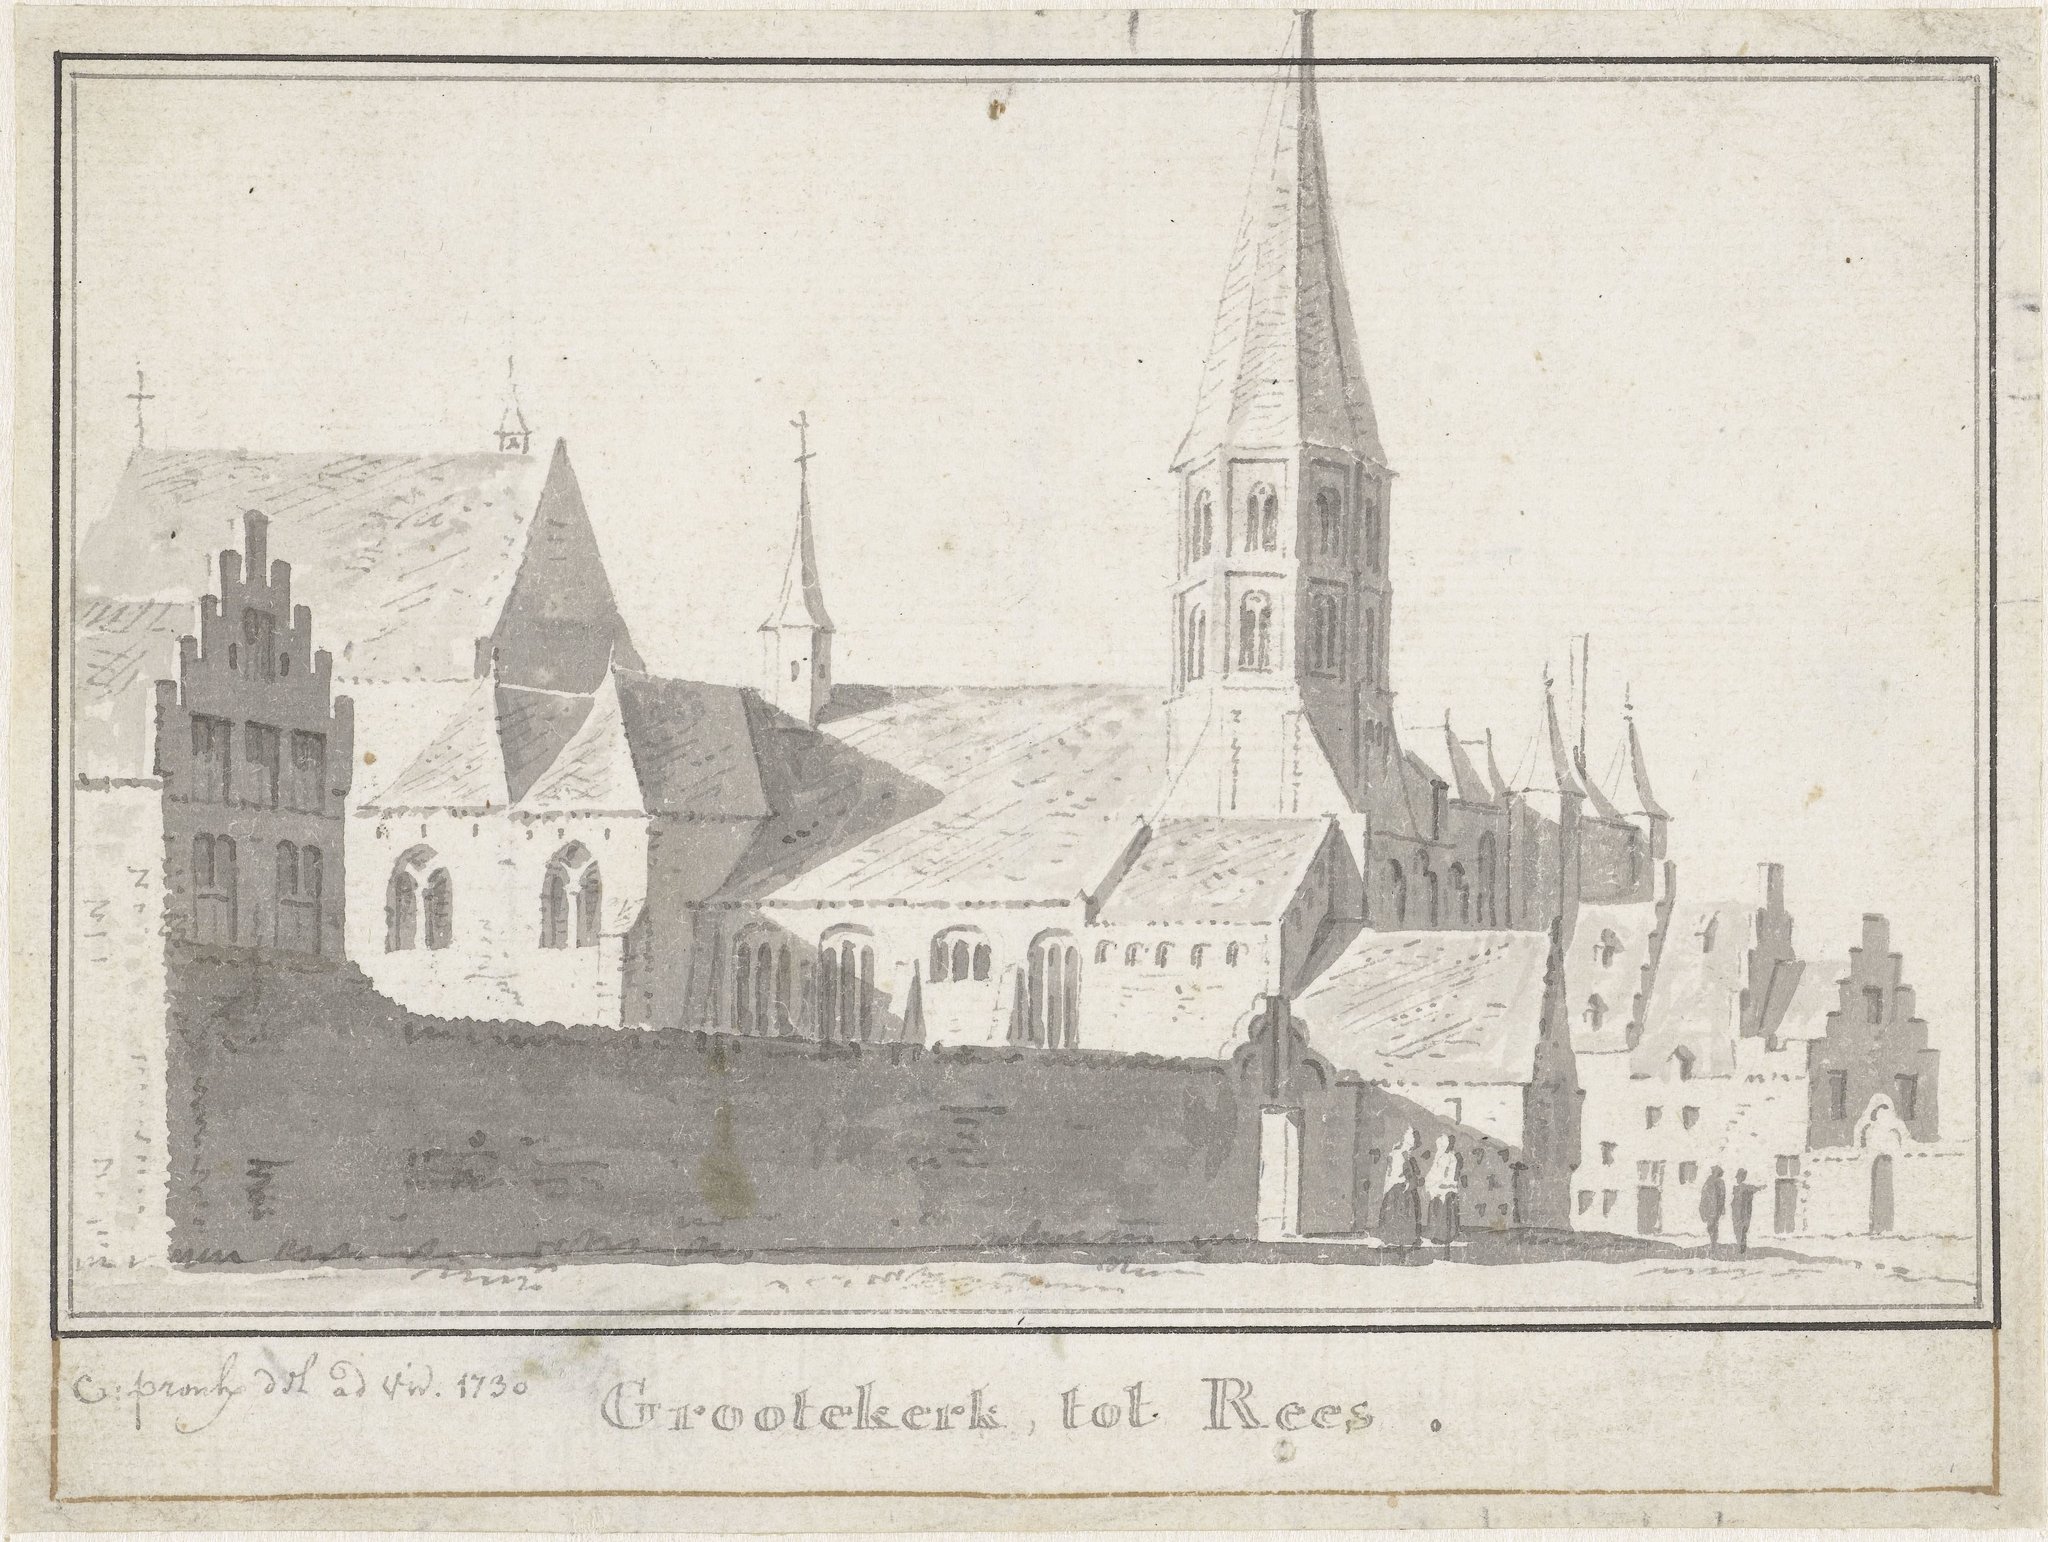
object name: drawing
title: De kerk te Rees, Duitsland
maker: cornelis pronk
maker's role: draughtsman, painter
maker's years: 1691-1759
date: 1730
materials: ink, paper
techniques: brush, pen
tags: church (exterior), prospect of city, town panorama, silhouette of city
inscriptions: caption: ‘C: pronk del ad viv. 1730 / Grootekerk tot Rees’